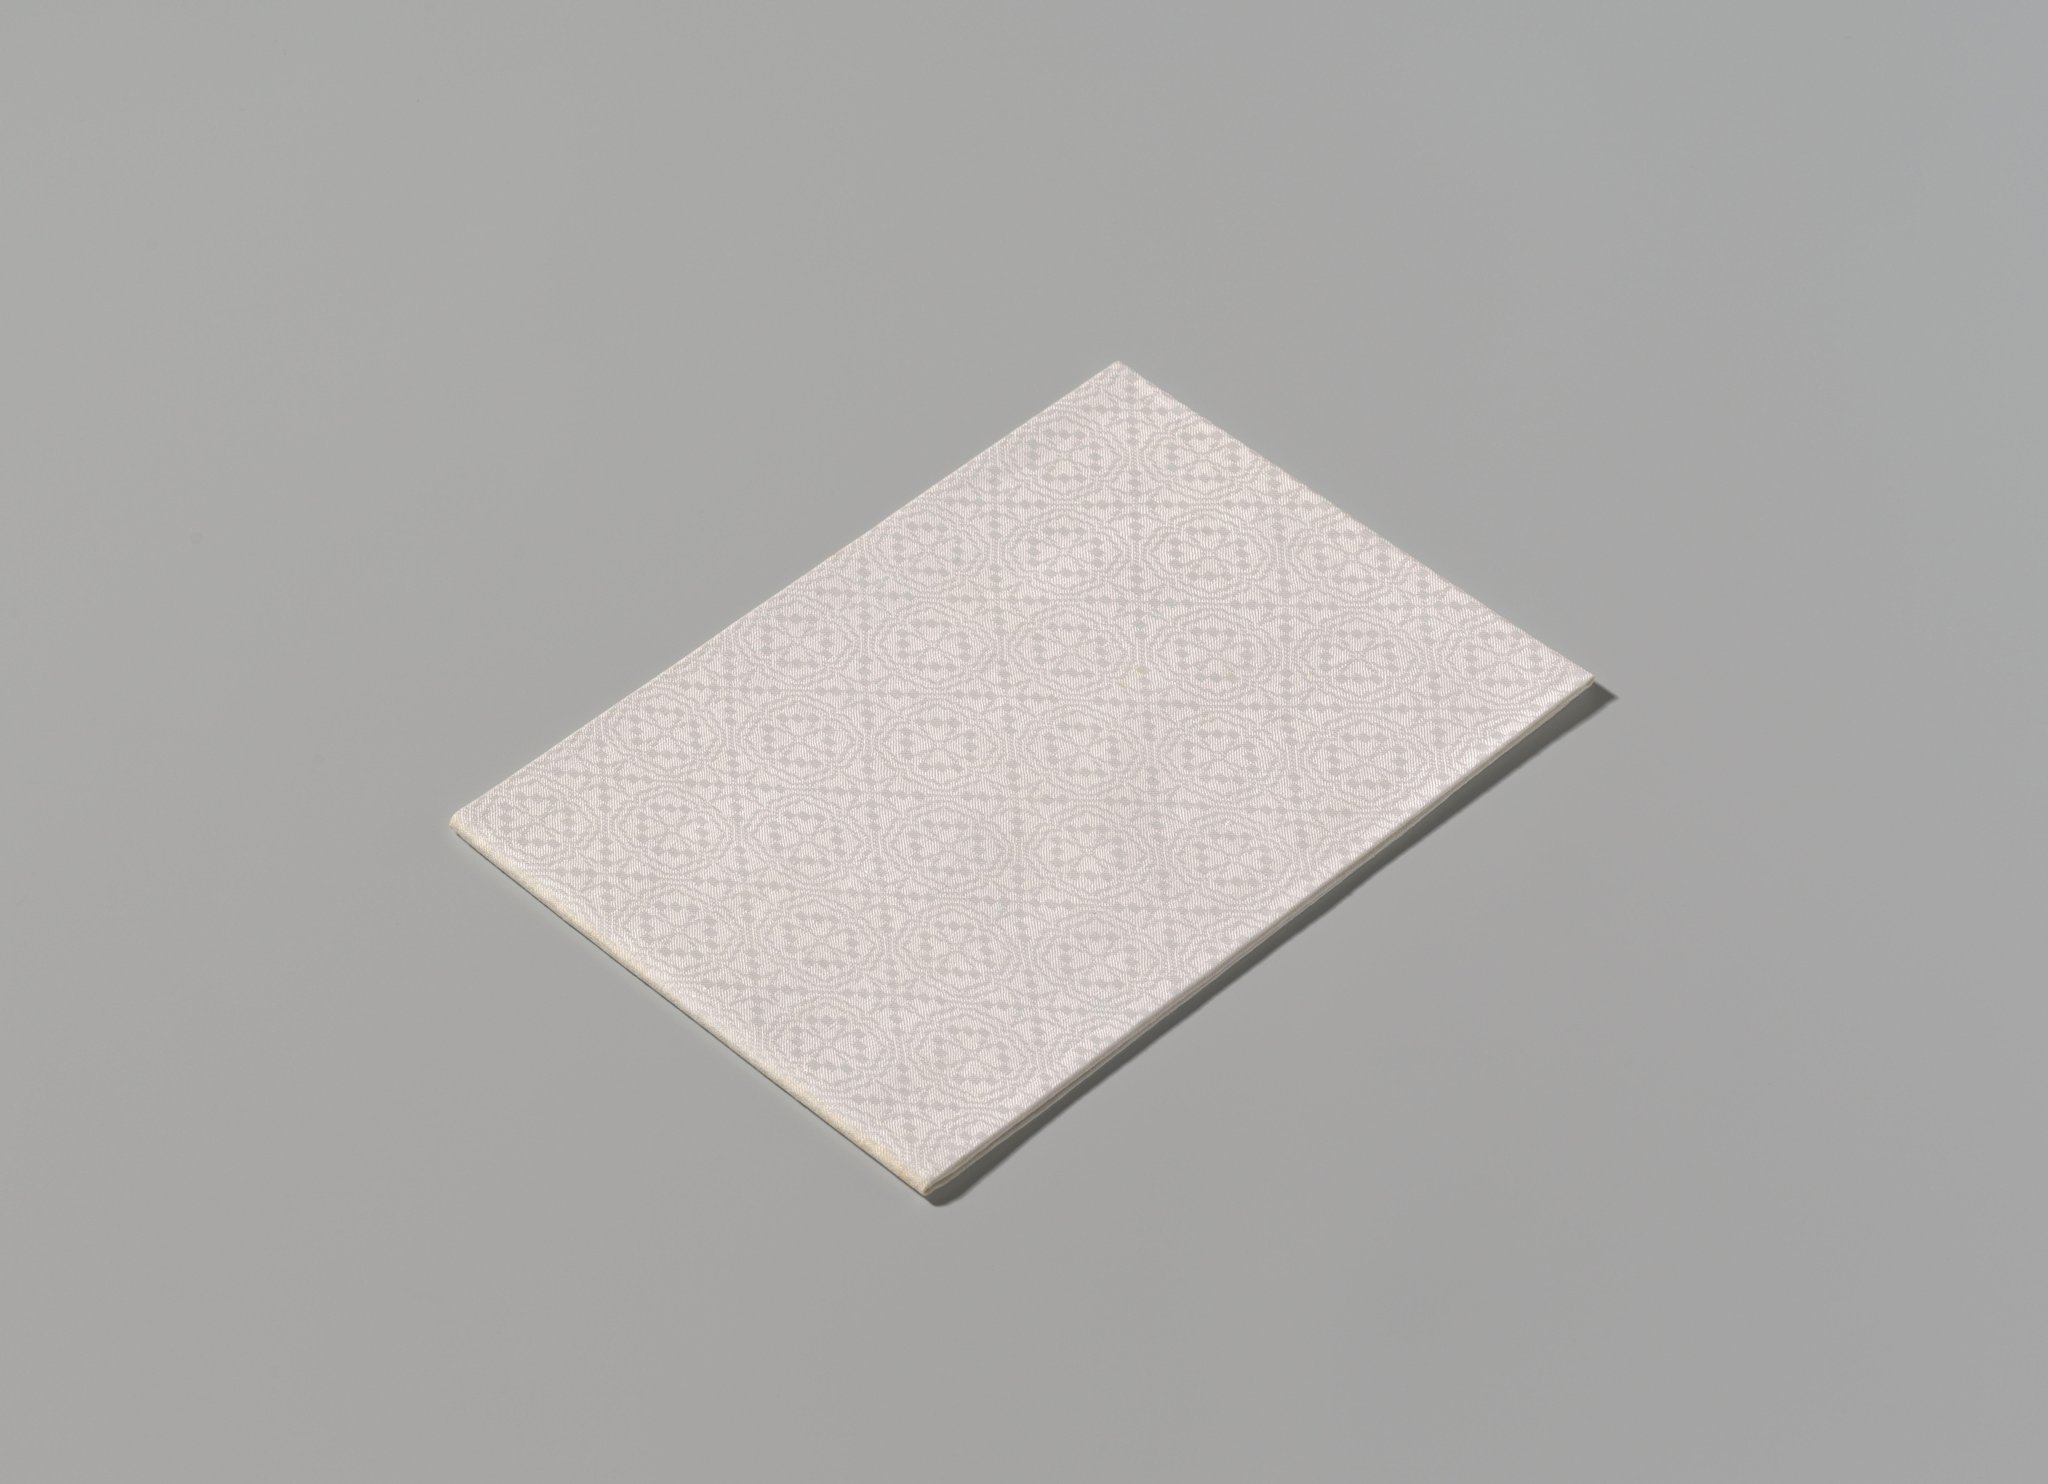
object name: napkin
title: Servet van wit linnen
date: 1640-1670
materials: linen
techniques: peeled fabric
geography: northern netherlands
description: Wit linnen servet. Pellen keper. Merk TC en 22.